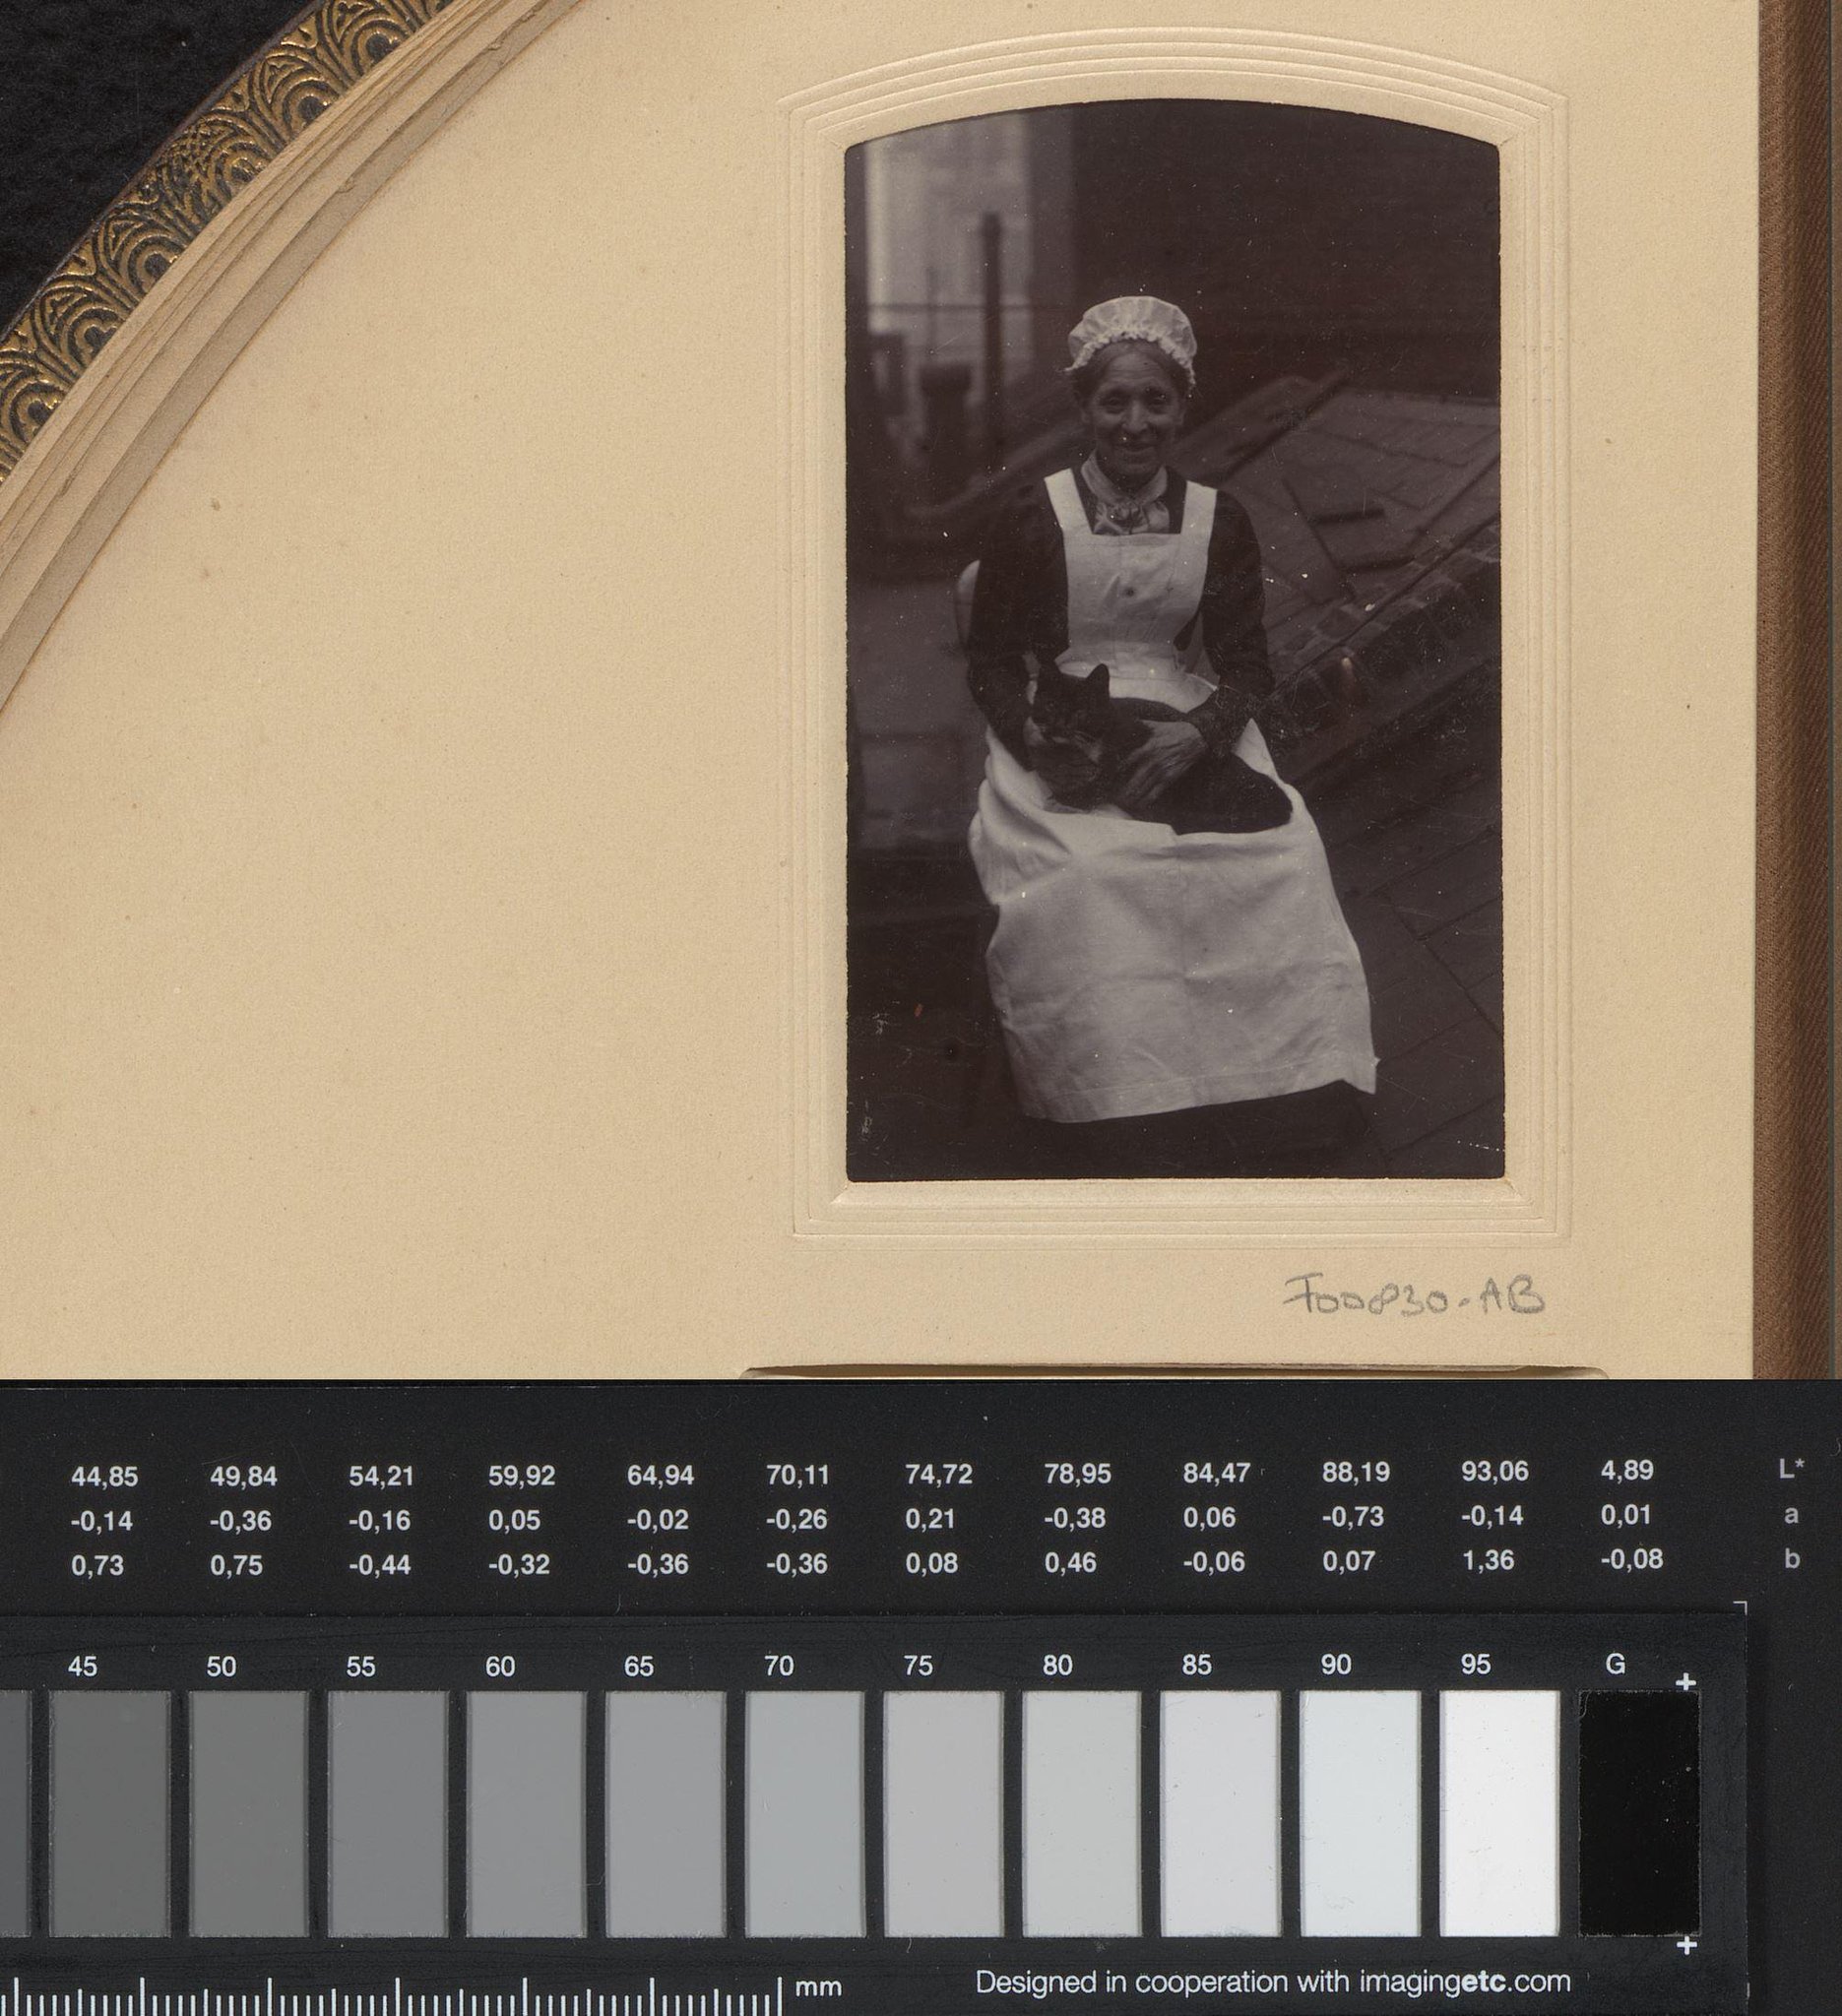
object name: album leaf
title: Portret ven een zittende dienstbode met een kat op schoot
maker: john h. williams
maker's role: fotograaf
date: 1890-1910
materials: cardboard, photographic support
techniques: collodion silver print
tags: sitting figure - aa - female human figure, cat, historical persons, house personnel, servants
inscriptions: inscription: ‘John H. Williams/ Photographer/ 42, Hornsey Park Rd. London N.’